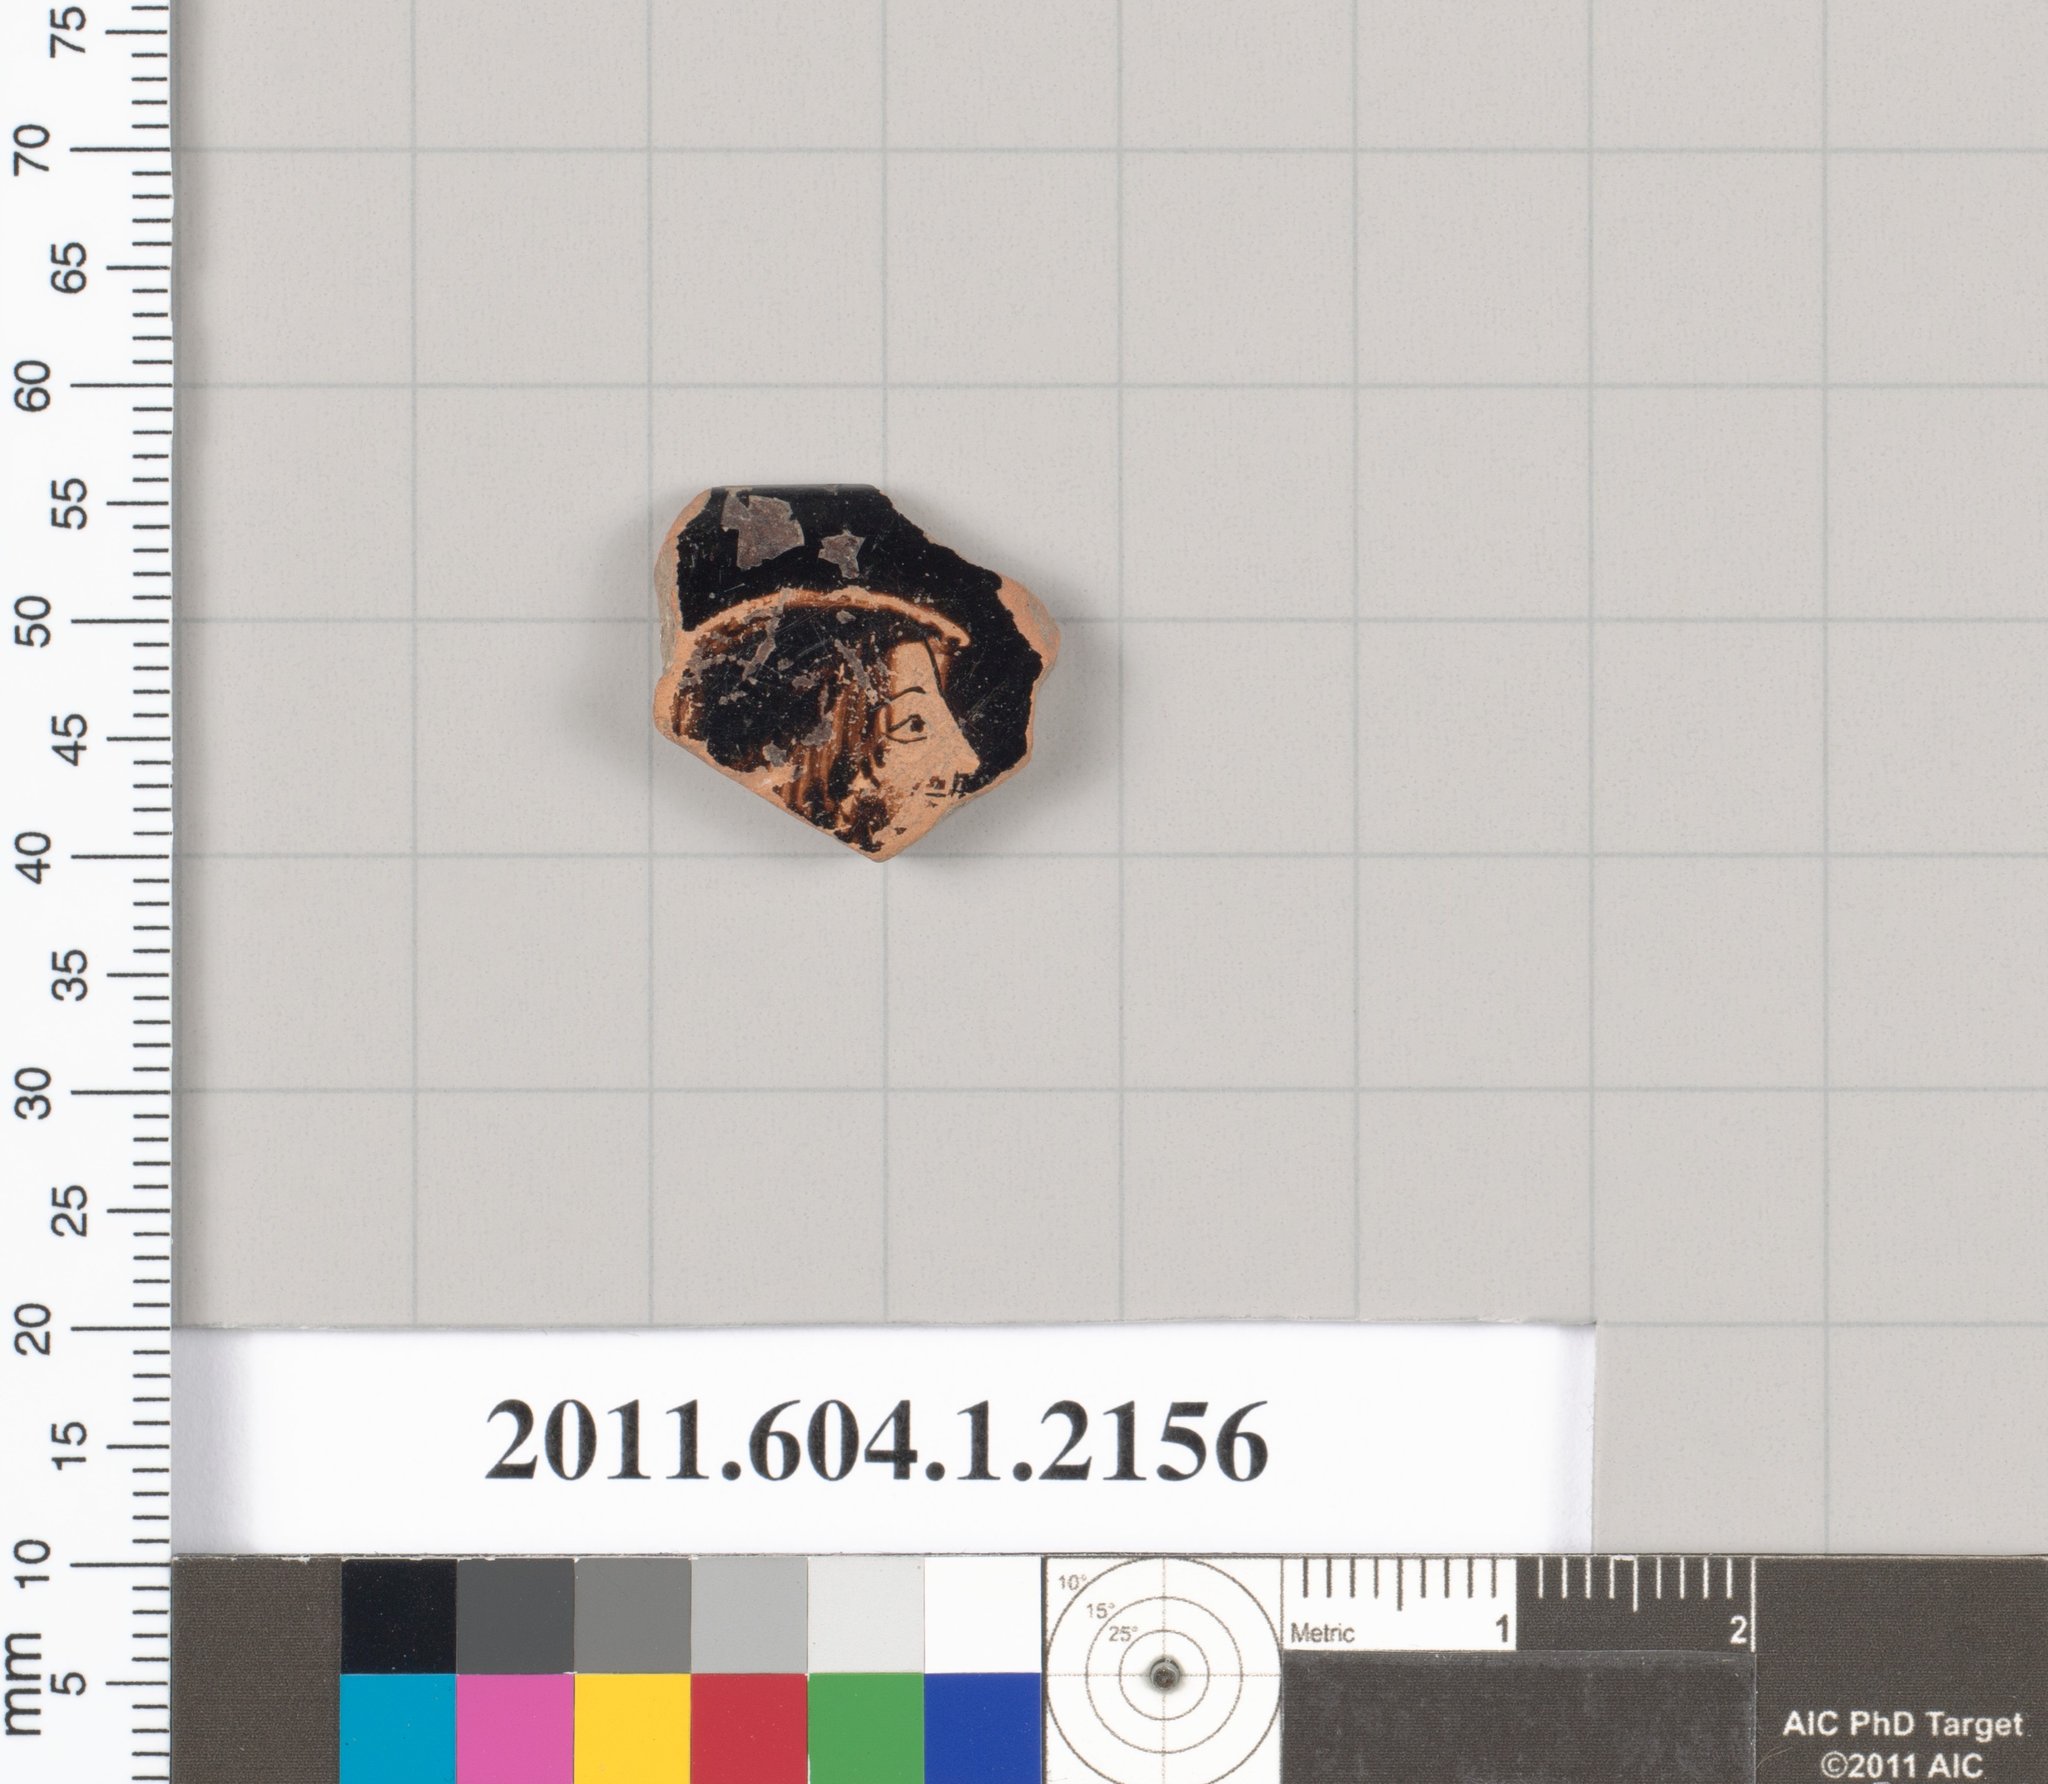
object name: kylix fragment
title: Terracotta rim fragment of a kylix (drinking cup)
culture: greek, attic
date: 475-451 BCE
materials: terracotta